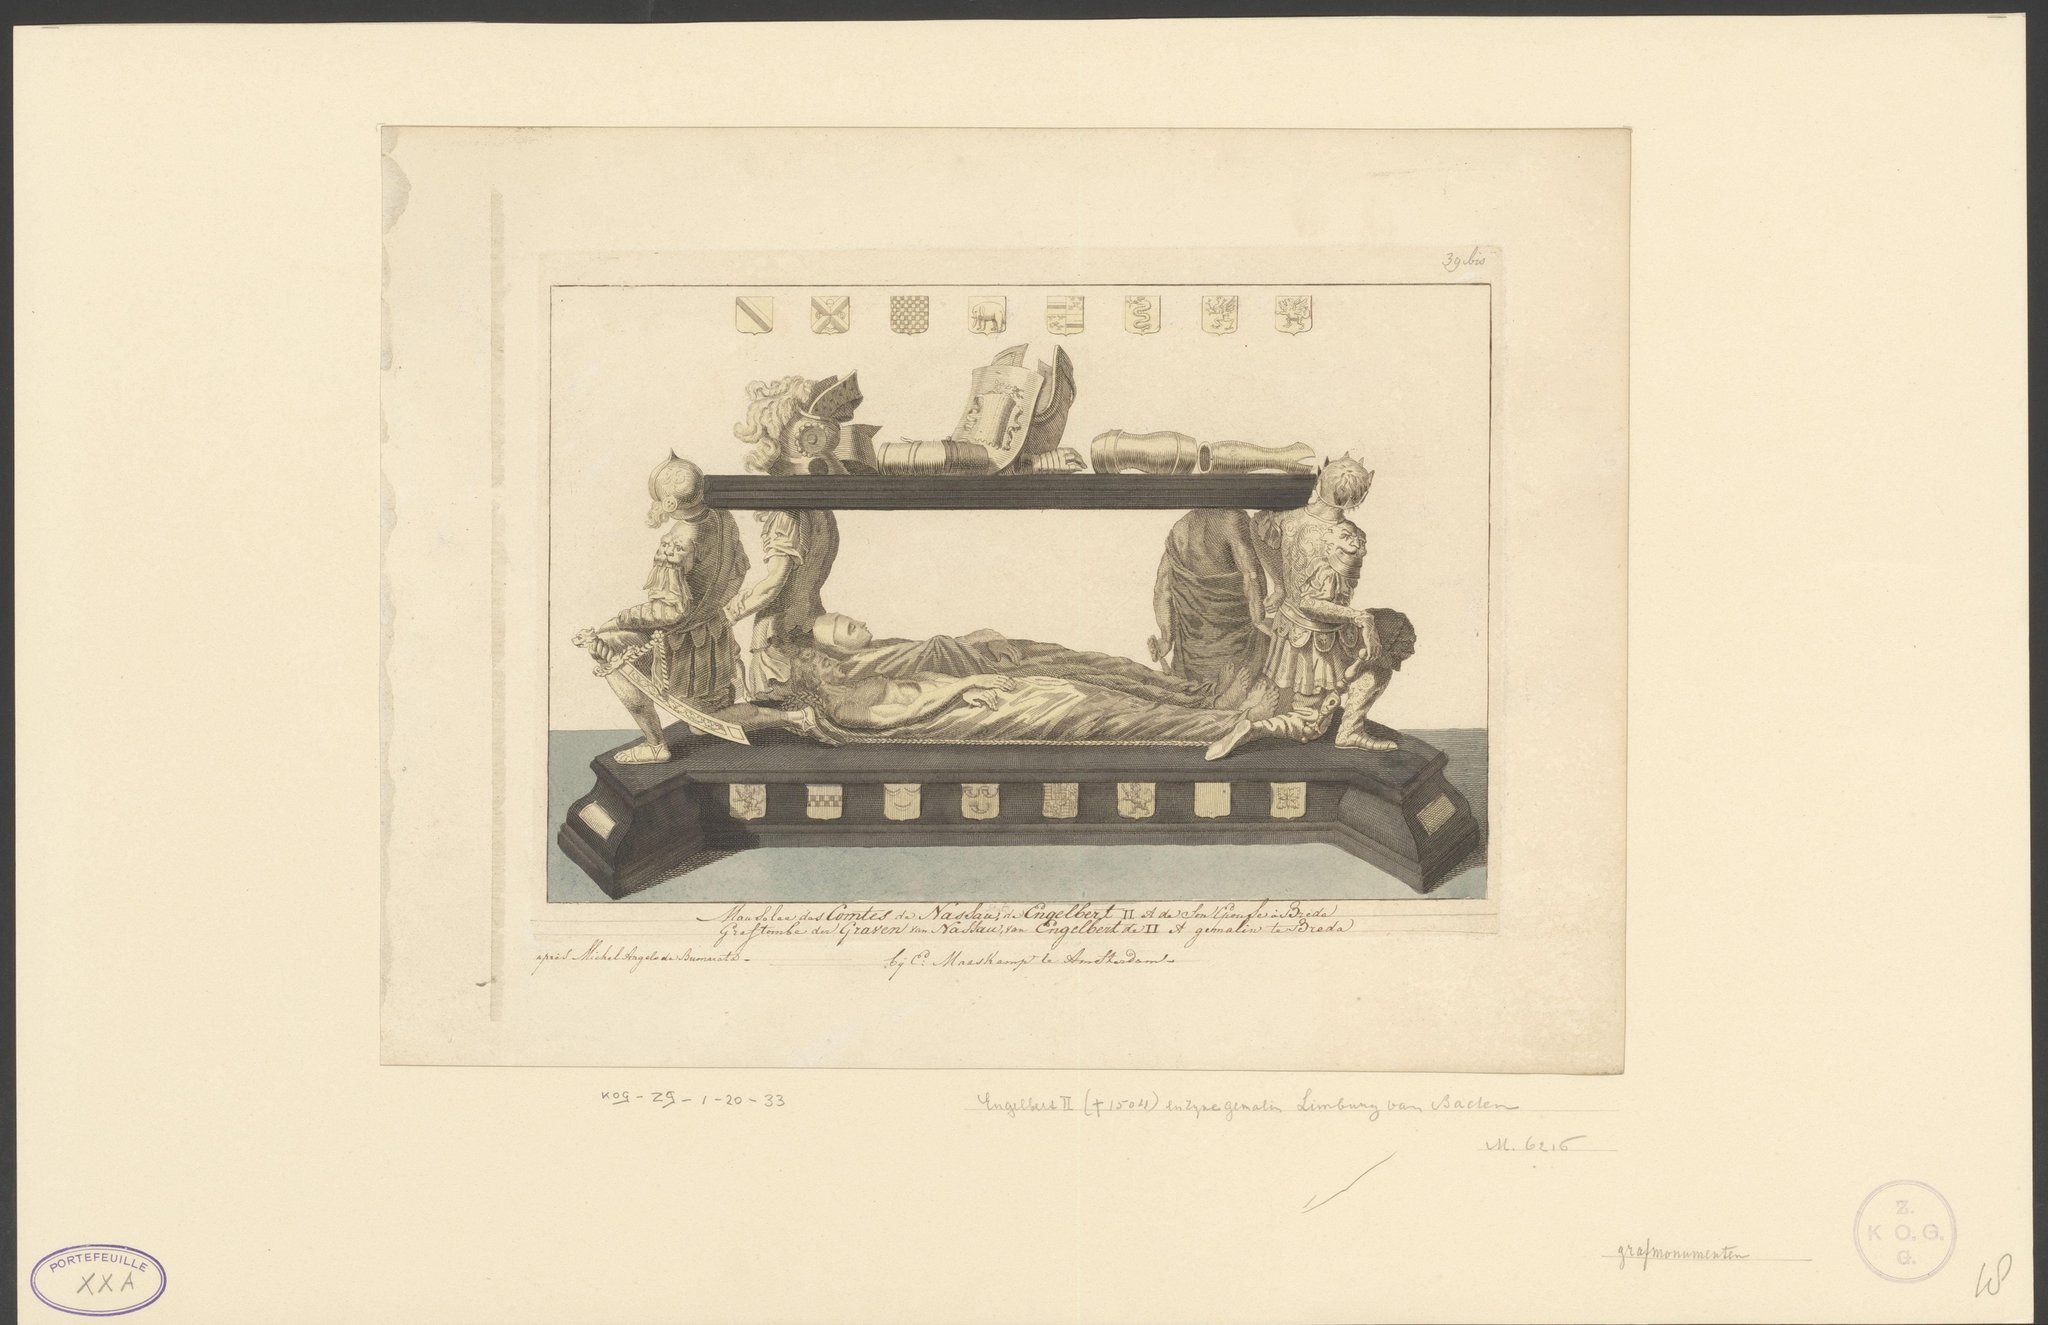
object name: print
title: Praalgraf van Engelbrecht II graaf van Nassau-Dillenburg-Breda en Cimburga van Baden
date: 1787-1834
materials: paper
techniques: etching, hand coloring, writing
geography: amsterdam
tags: brussels, grave-building, monumental tomb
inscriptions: collector's mark: Lugt 1641, stamp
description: Onderwerpsrubrieken binnen de Atlas Zeden en Gewoonten: Zeden en Gewoonten in Engeren Zin, Des menschen beging, midden en einde, Grafmonumenten.